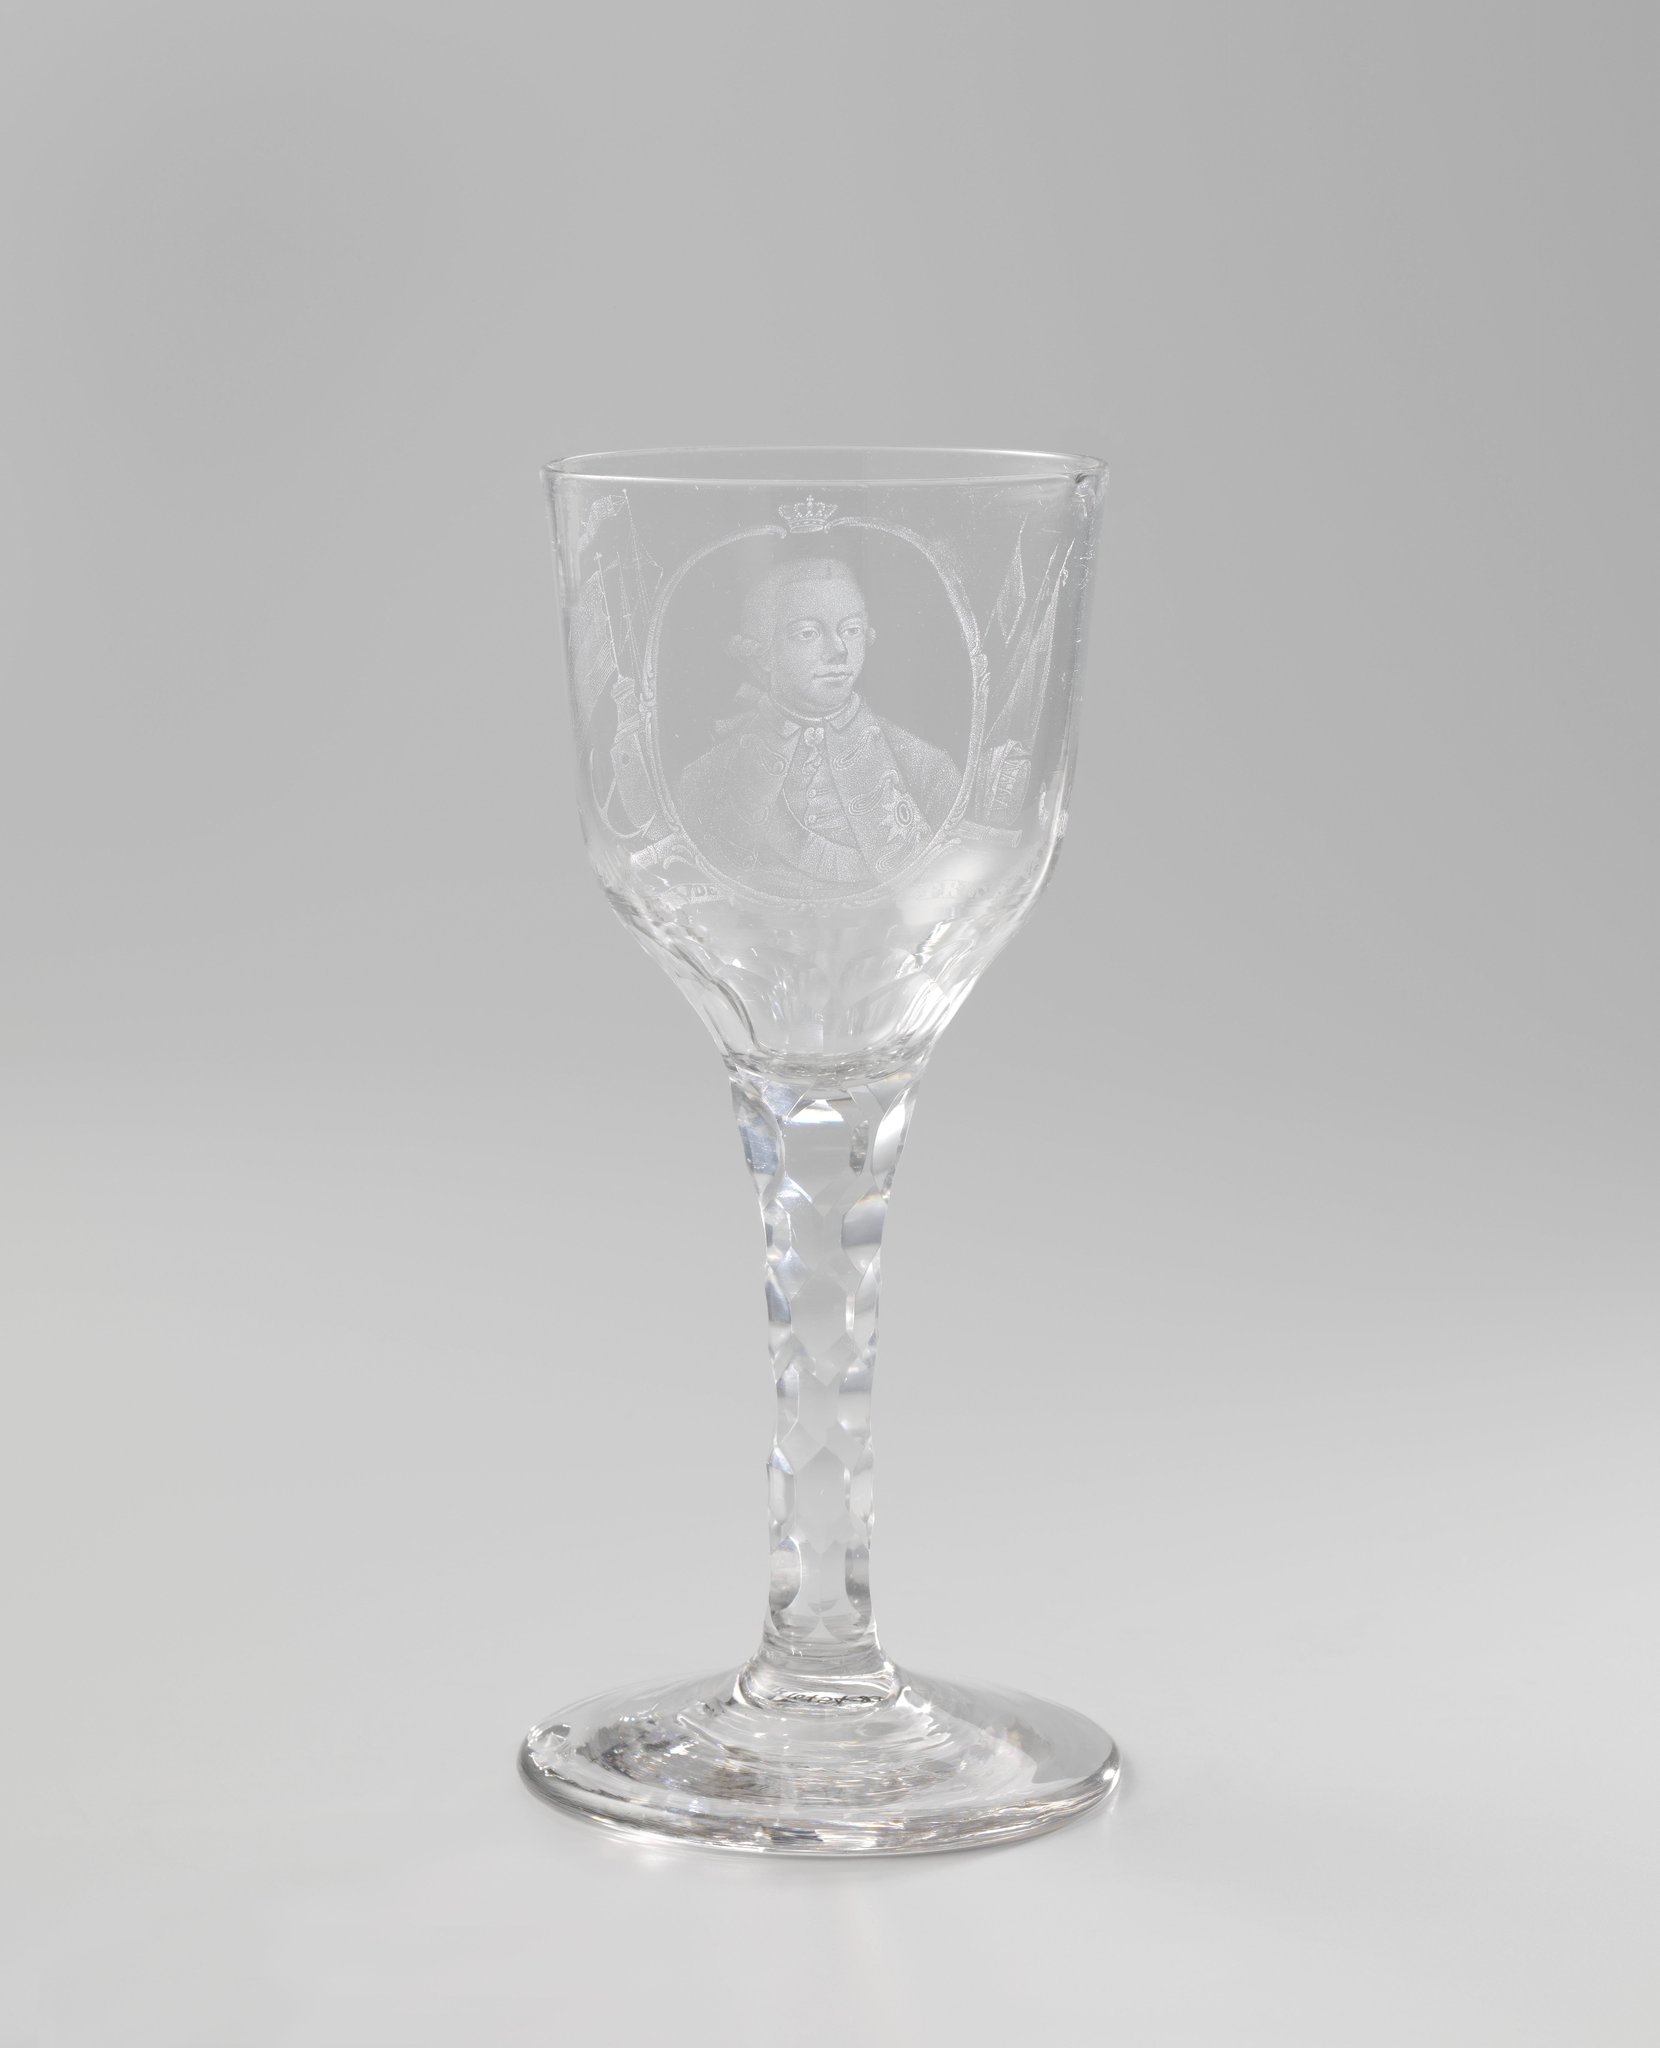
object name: goblet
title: Kelkglas met een portret van Willem V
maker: david wolff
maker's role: glasgraveur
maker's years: 1732-1798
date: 1780-1798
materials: glass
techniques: glassblowing, grinding, engraving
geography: northern netherlands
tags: the hague, william v (prince of orange), historical persons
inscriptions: inscription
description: Glas met hiel-ojiefvormige kelk op rechte, naar boven iets uitlopende stam, geslepen met holle langgerekte zeshoeken en opgedreven voet. Op de kelk in stippelgravure een ovaal gekroond medaillon met borstbeeld van een man (Willem V), hoofd iets naar rechts; achter het medaillon uit komen vlaggen, masten, zeevaart- en krijgsattributen, onder het medaillon banderol met opschrift: WILLEM DE VDE // PRINS VAN ORANIE.